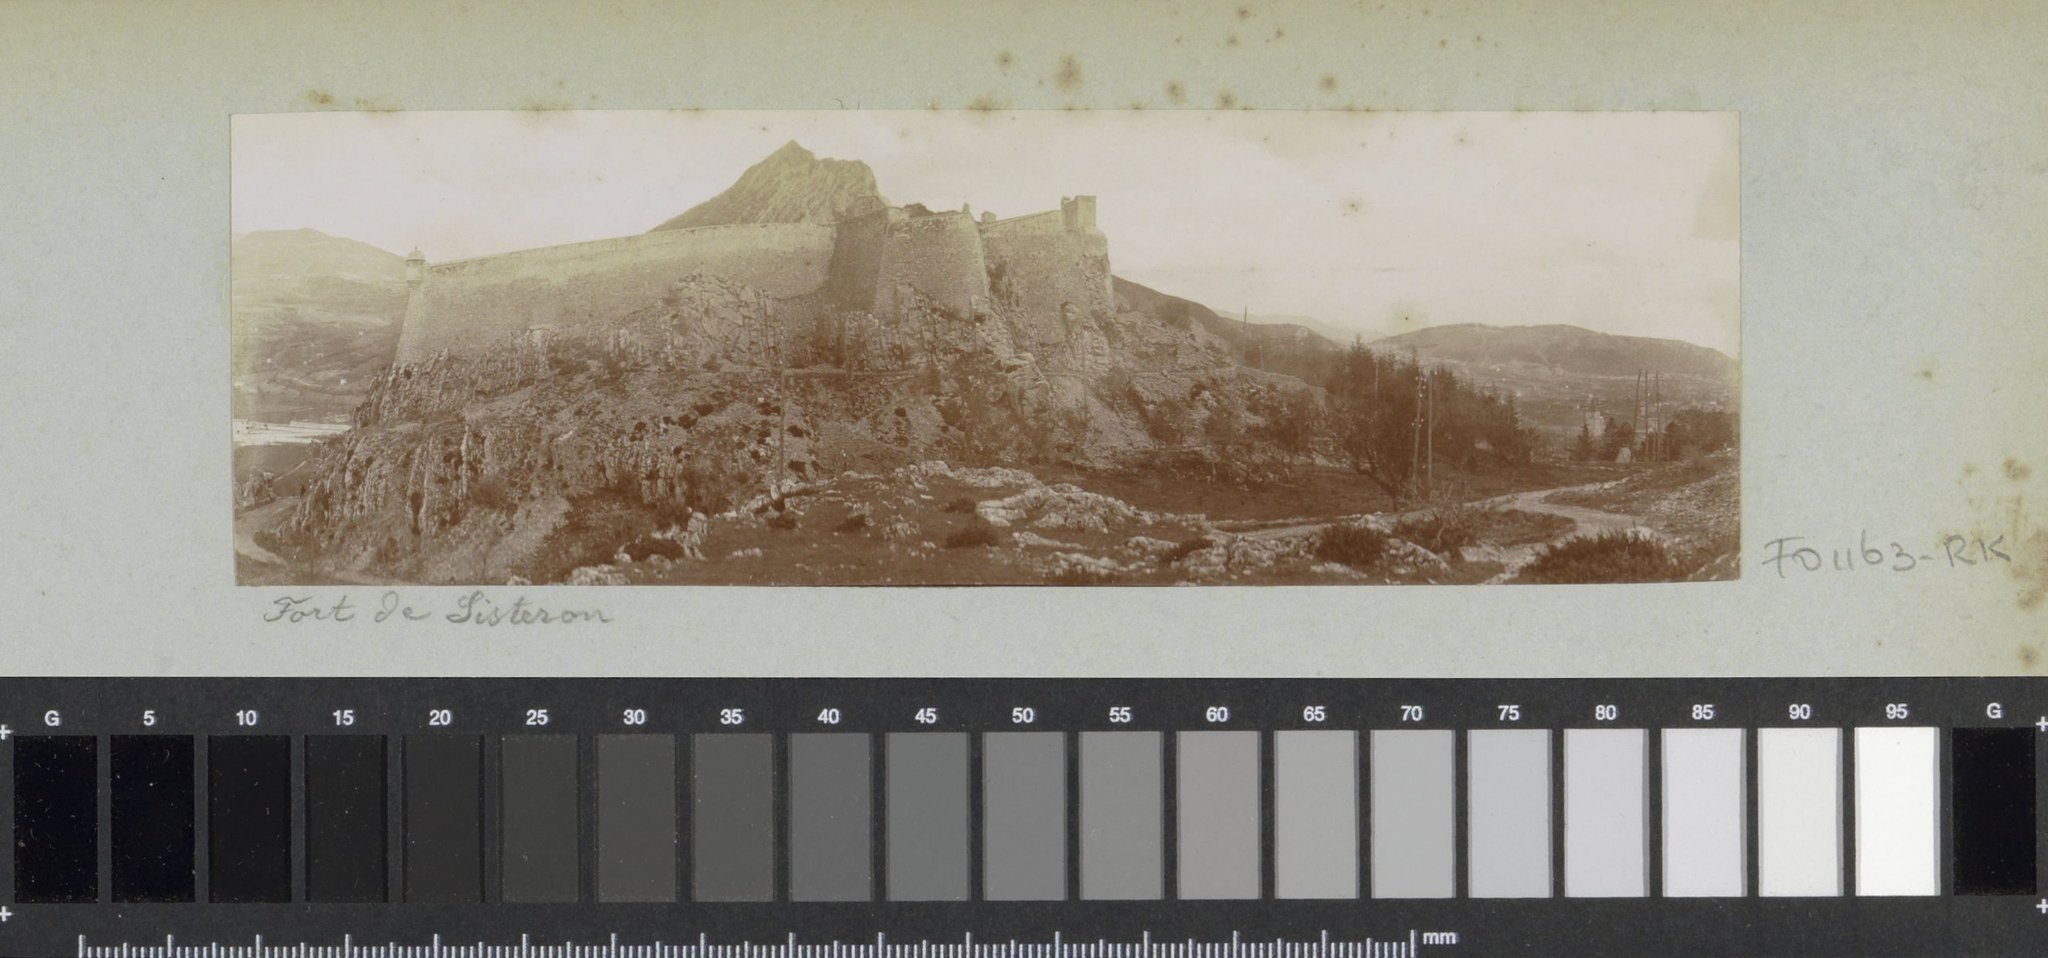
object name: panoramic photograph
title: Gezicht op het Fort van Sisteron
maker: delizy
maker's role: manufacturer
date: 1903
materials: paper, photographic support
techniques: gelatin silver print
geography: sisteron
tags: prospect of village, silhouette of village, fortress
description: Onderdeel van Fotoalbum van een Franse amateurfotograaf met opnames van uitstapjes in Frankrijk, Spanje, België, Luxemburg en Nederland, de eerste automobielen en autoraces.